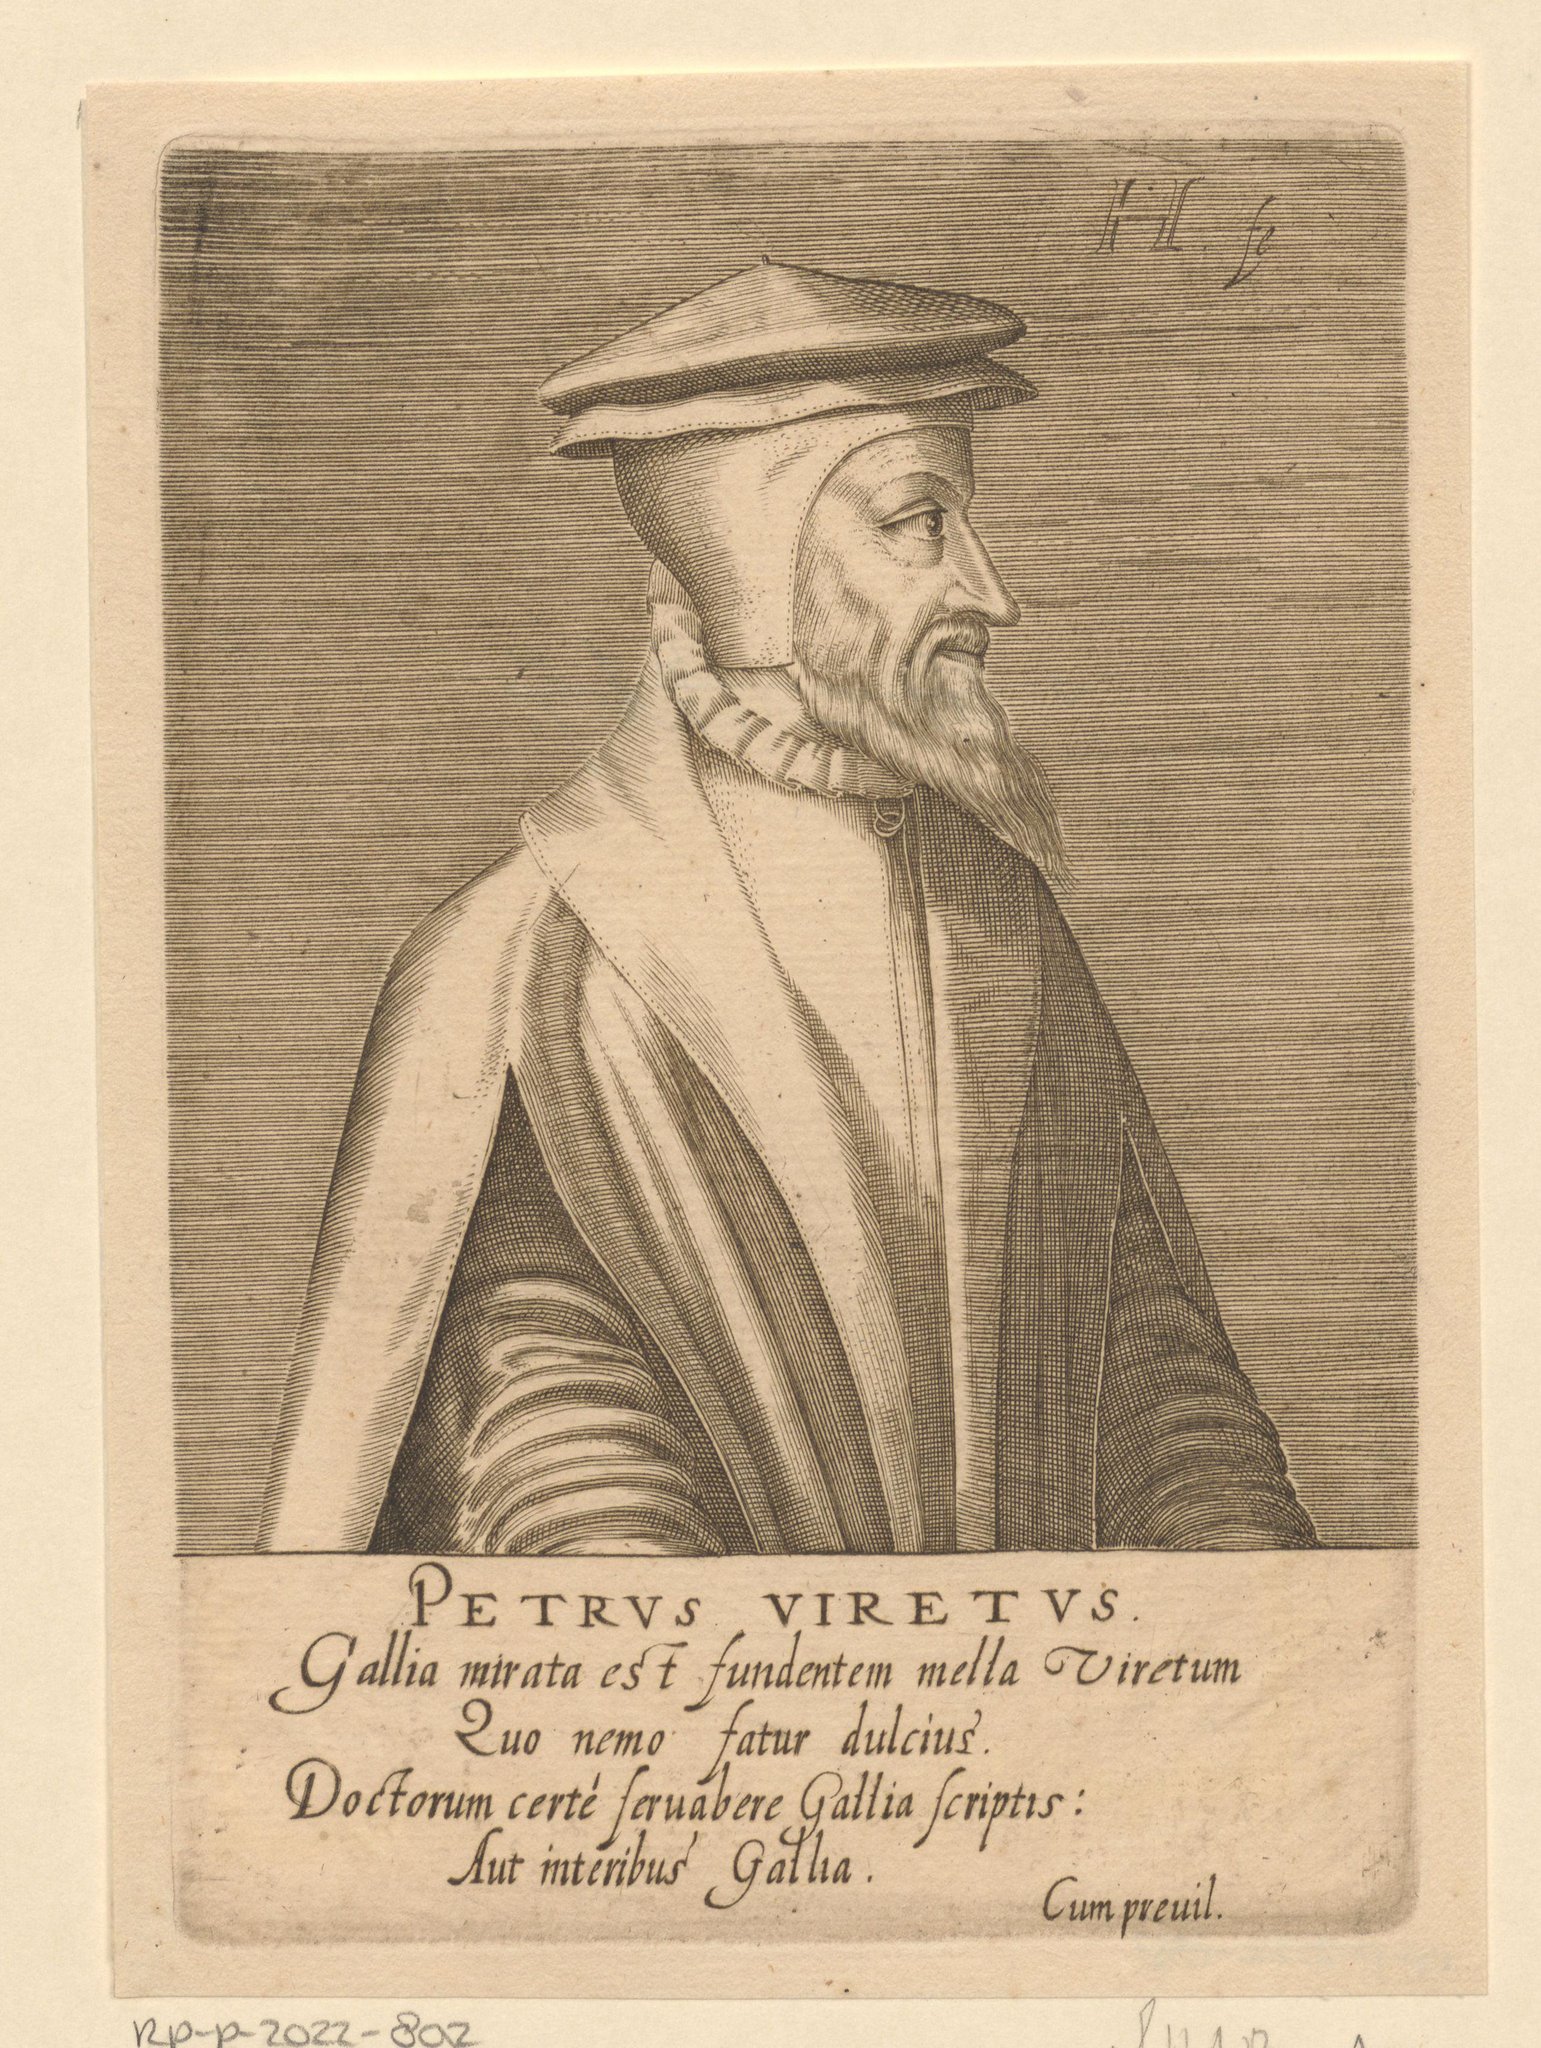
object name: print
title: Portret van Pierre Viret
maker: hendrick hondius (i)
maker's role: draughtsman, print maker, publisher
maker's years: 1573-1650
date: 1599-1604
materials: paper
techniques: engraving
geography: the hague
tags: theologian, historical persons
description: Prent ook gebruikt in publicaties uit 1603 en 1604, zie New Hollstein. Met tekst in boekdruk op verso is de prent gebruikt in 'Praestantium aliquot theologorum', 1602.